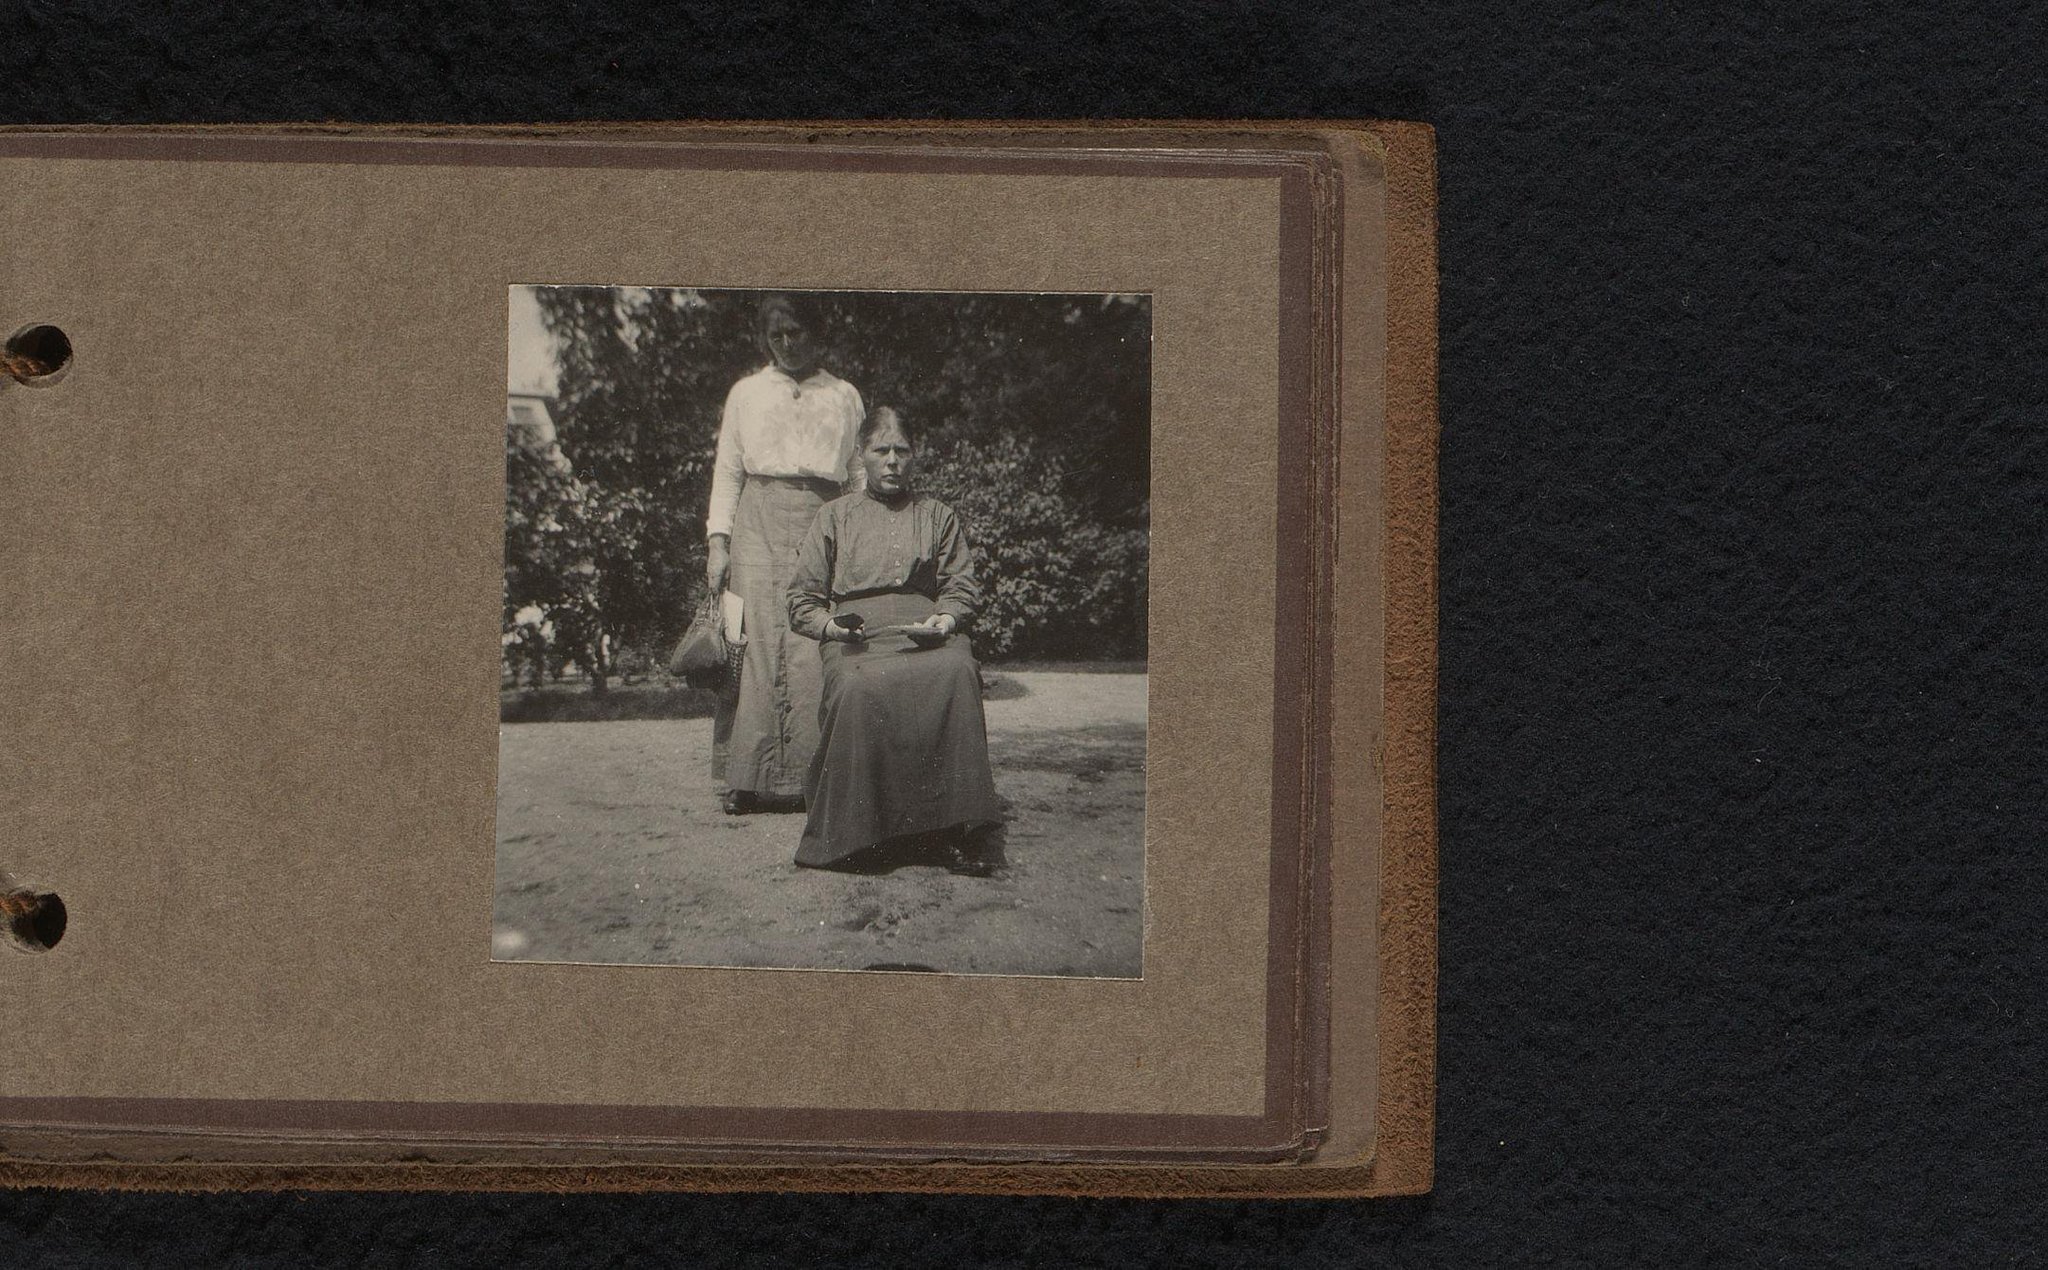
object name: photograph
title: Twee vrouwen in een tuin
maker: Anonymous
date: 1900-1930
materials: paper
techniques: gelatin silver print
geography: netherlands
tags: historical persons not known by name - bb - woman, garden